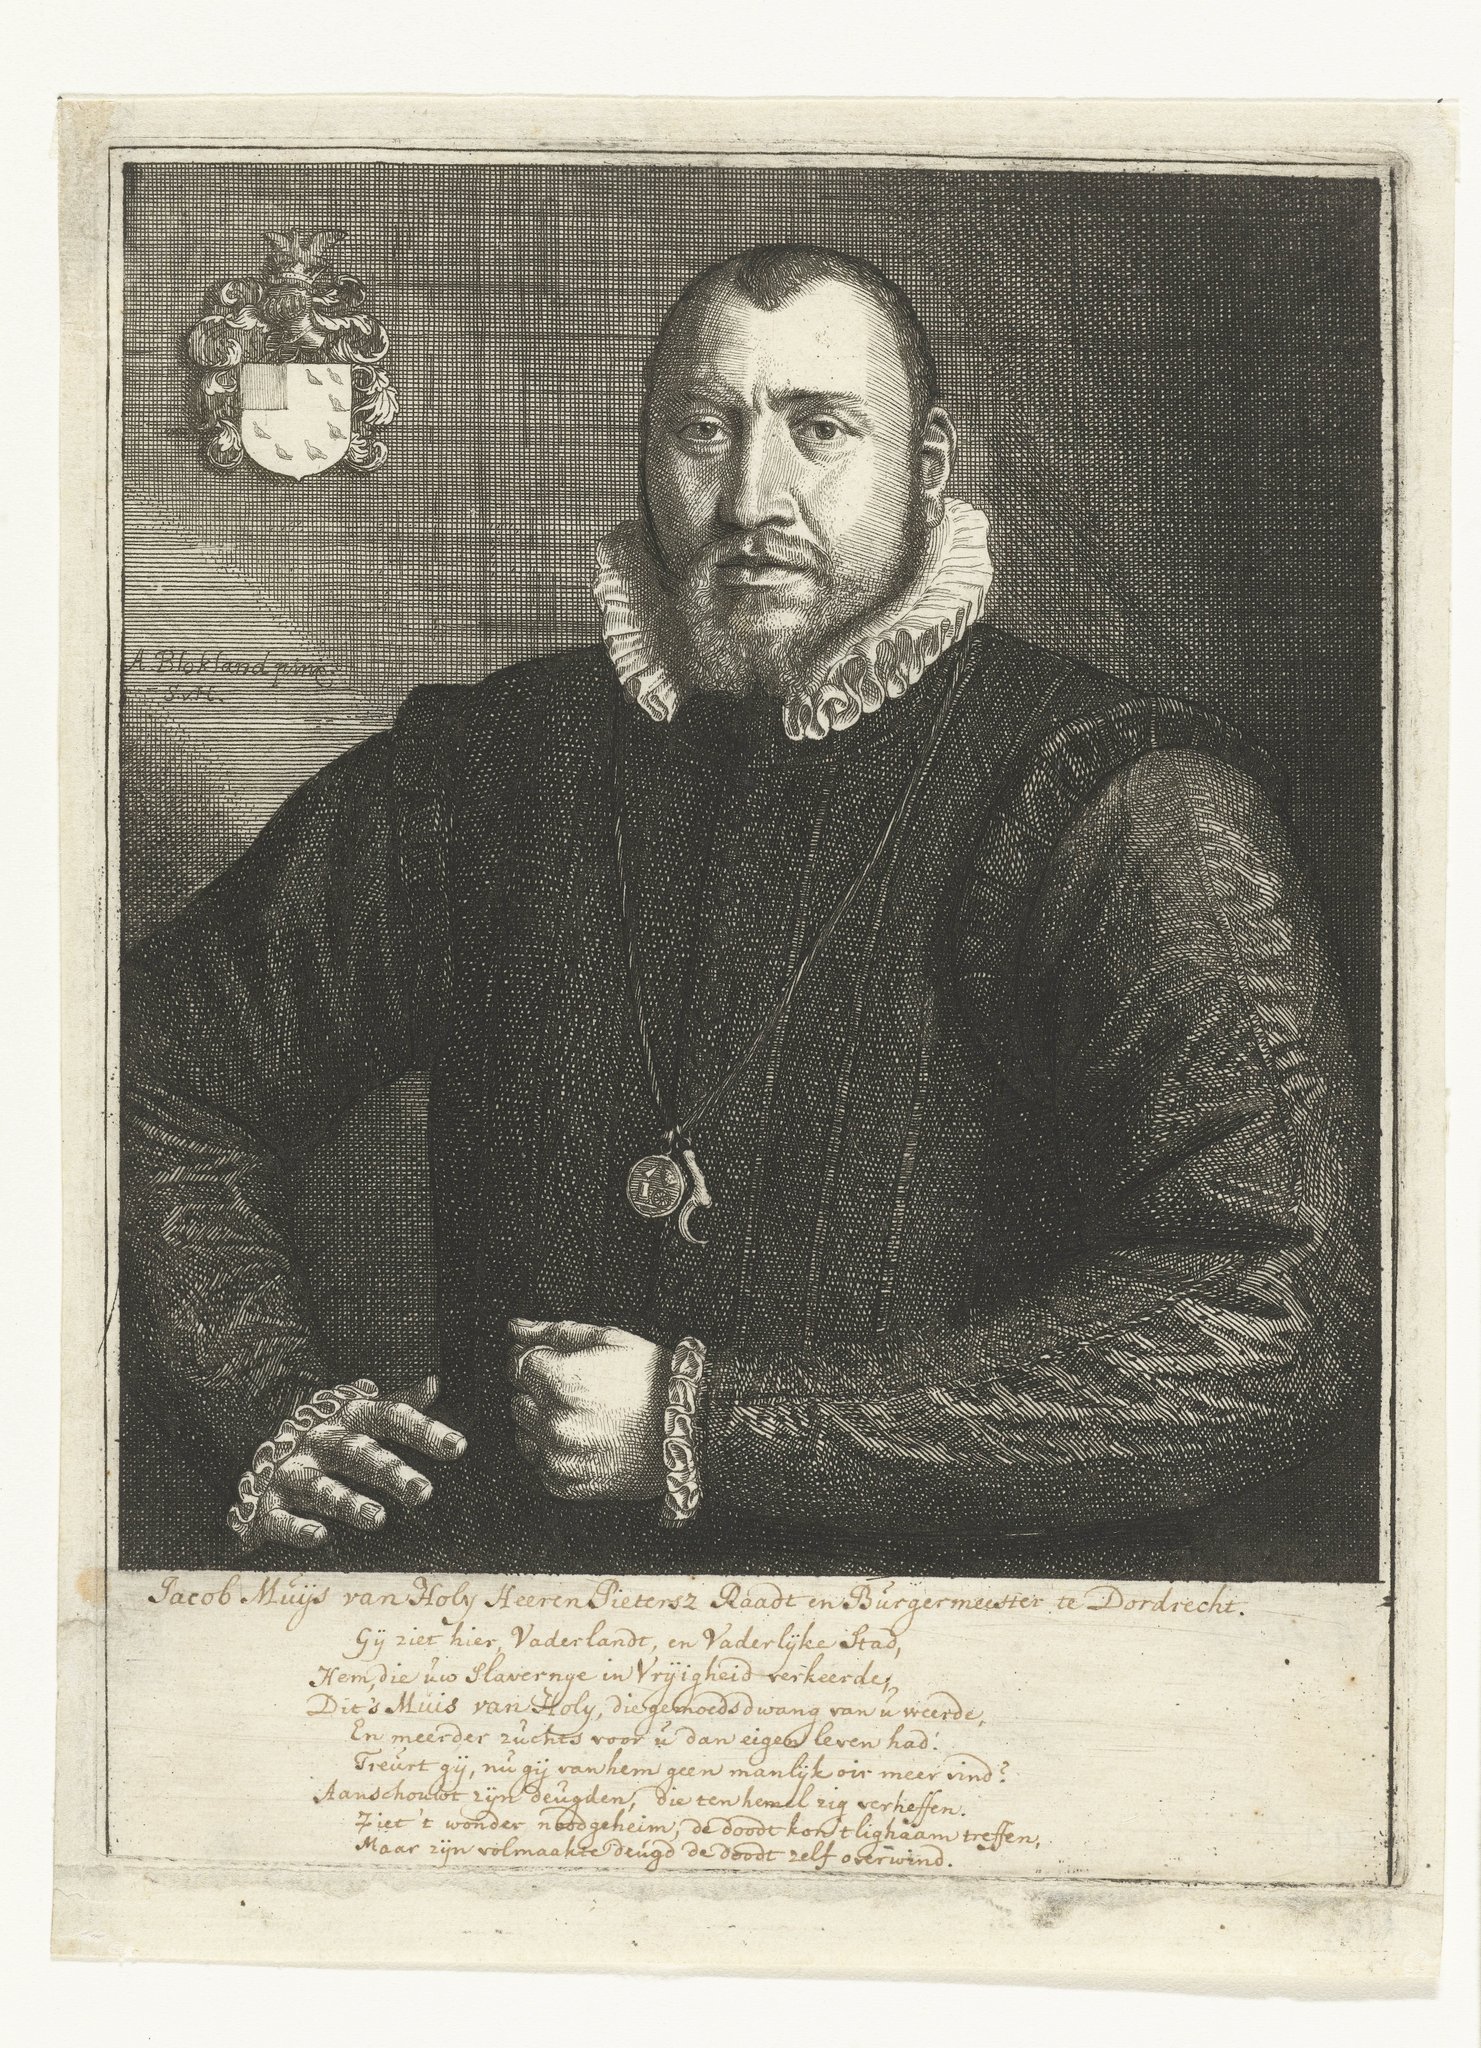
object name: print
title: Portret van Jacob Muys van Holy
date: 1648-1677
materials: paper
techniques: etching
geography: netherlands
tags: dordrecht, mayor, burgomaster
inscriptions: title: ‘Jacob Muijs van Holy Heeren Pietersz Raadt en Burgermeester te Dordrecht.’, collector's mark: Lugt 2228a, inscription: ‘Gij ziet hier Vaderlandt en Vadelrijke stad (...) Maar zijn volmaakte deugd de doodt zelf overwind.’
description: Jacob Muys van Holy, burgemeester van Dordrecht, ten halven lijve. Linksboven het wapen van Holy. Onder het portret een negenregelige tekst in het Nederlands, met de hand geschreven.